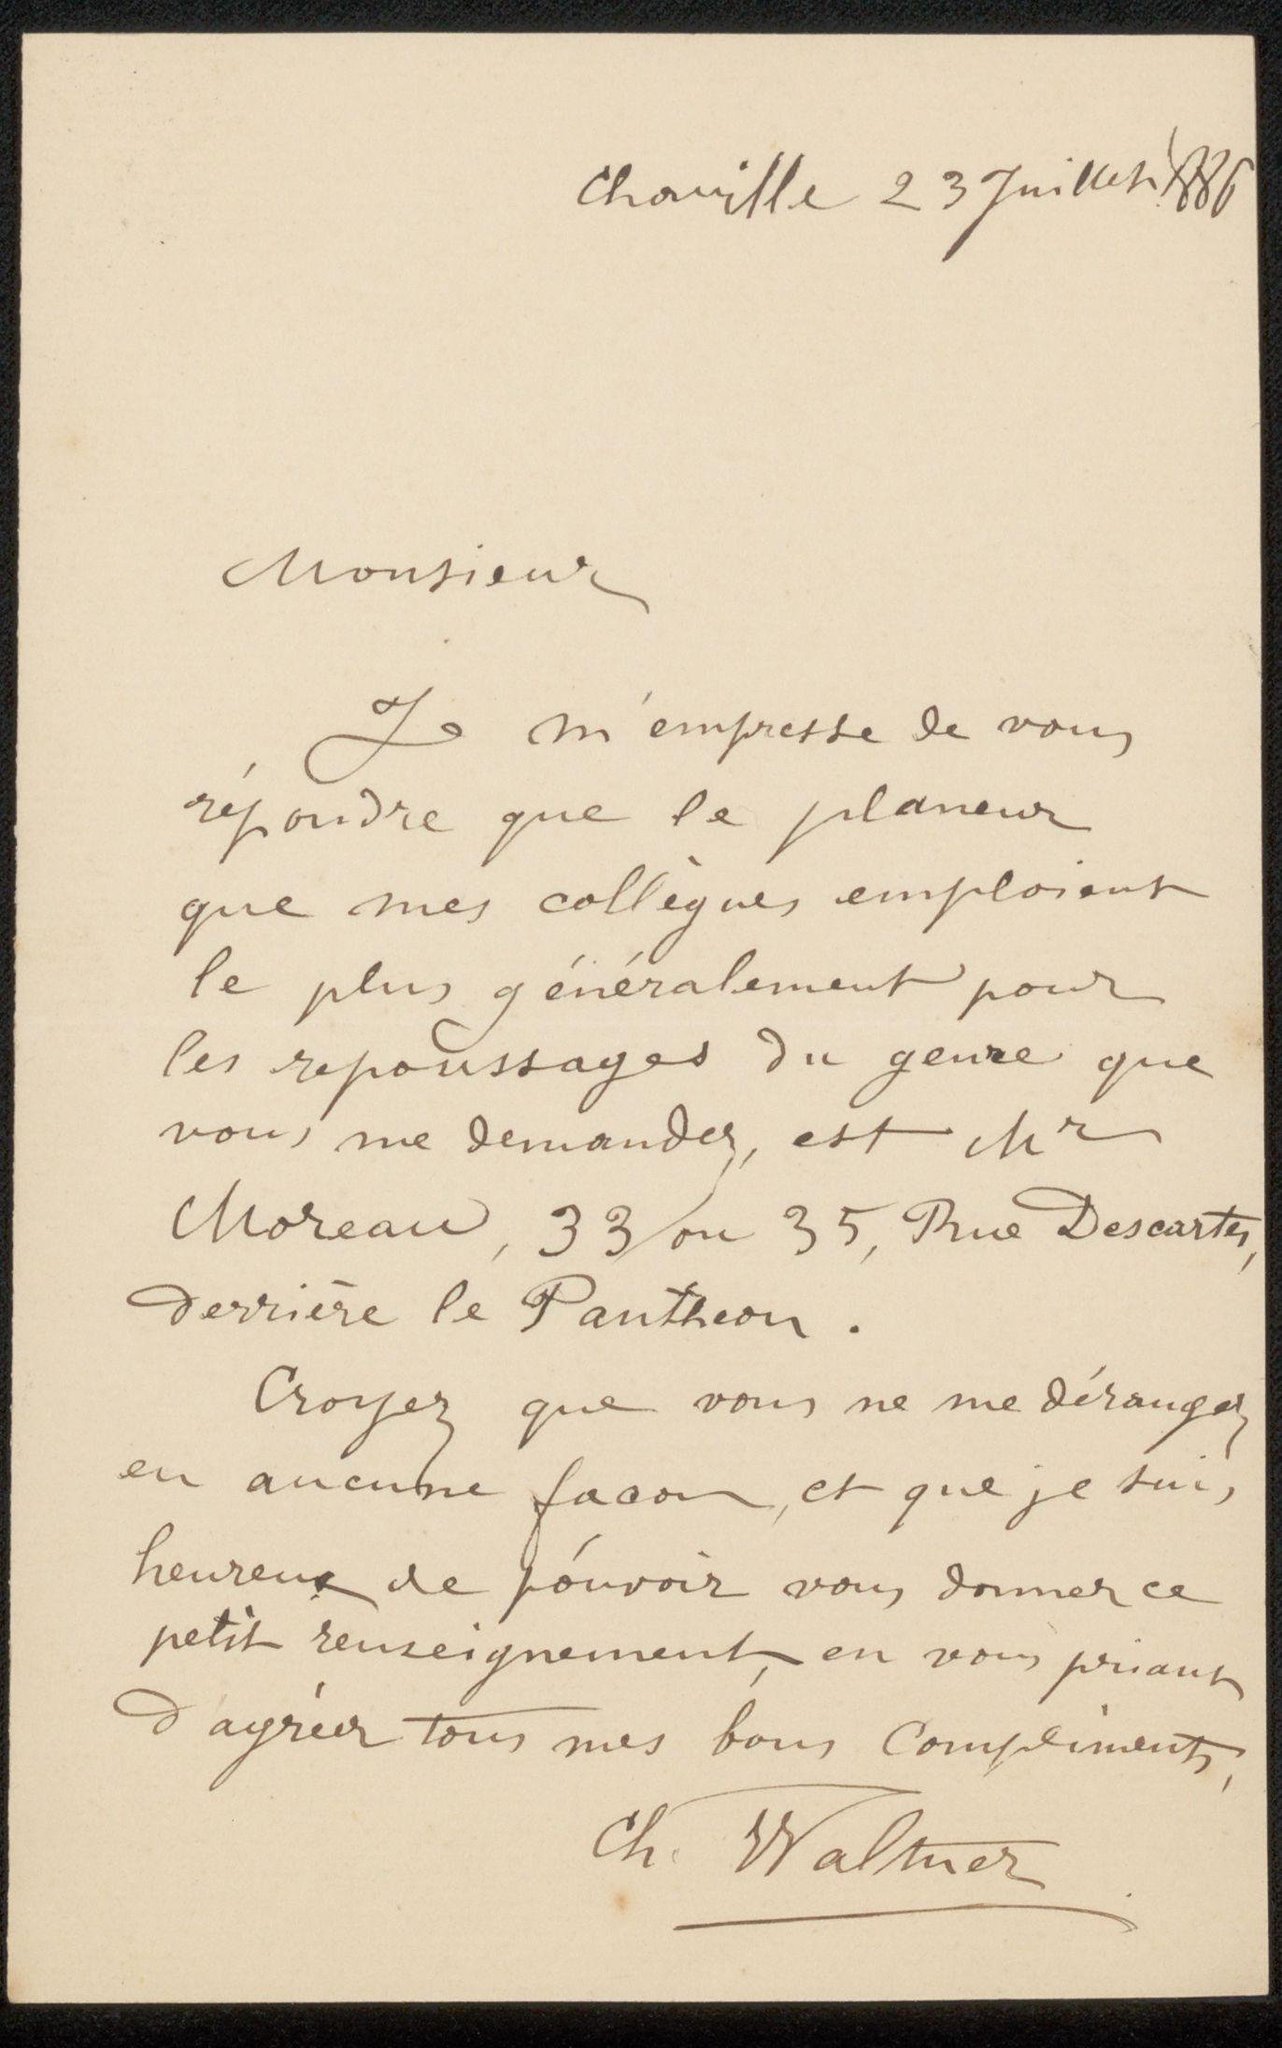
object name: letter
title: Brief aan Philip Zilcken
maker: charles albert waltner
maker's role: print maker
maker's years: 1846-1925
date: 1886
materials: ink, paper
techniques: pen, writing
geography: chaville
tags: gustave moreau, the hague, painter, draughtsman, philip zilcken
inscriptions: watermark, collector's mark: ‘RPK’